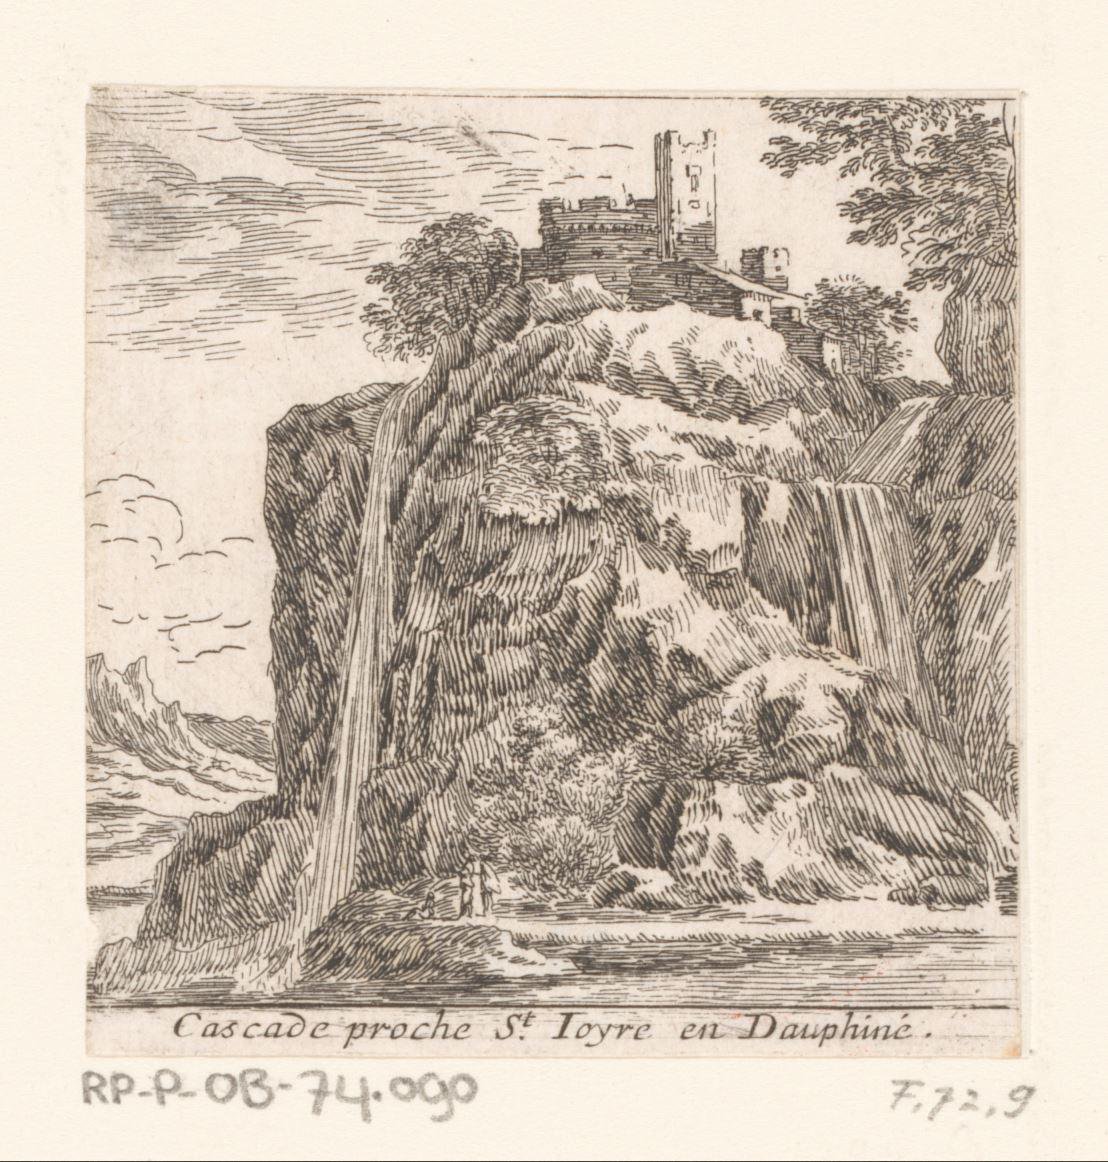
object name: print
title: Gezicht op een waterval met bovenaan een kasteel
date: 1631-1661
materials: paper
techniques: etching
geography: france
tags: waterfall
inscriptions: collector's mark: Lugt 240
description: Prent maakt deel uit van een ongenummerde serie van negen prenten.